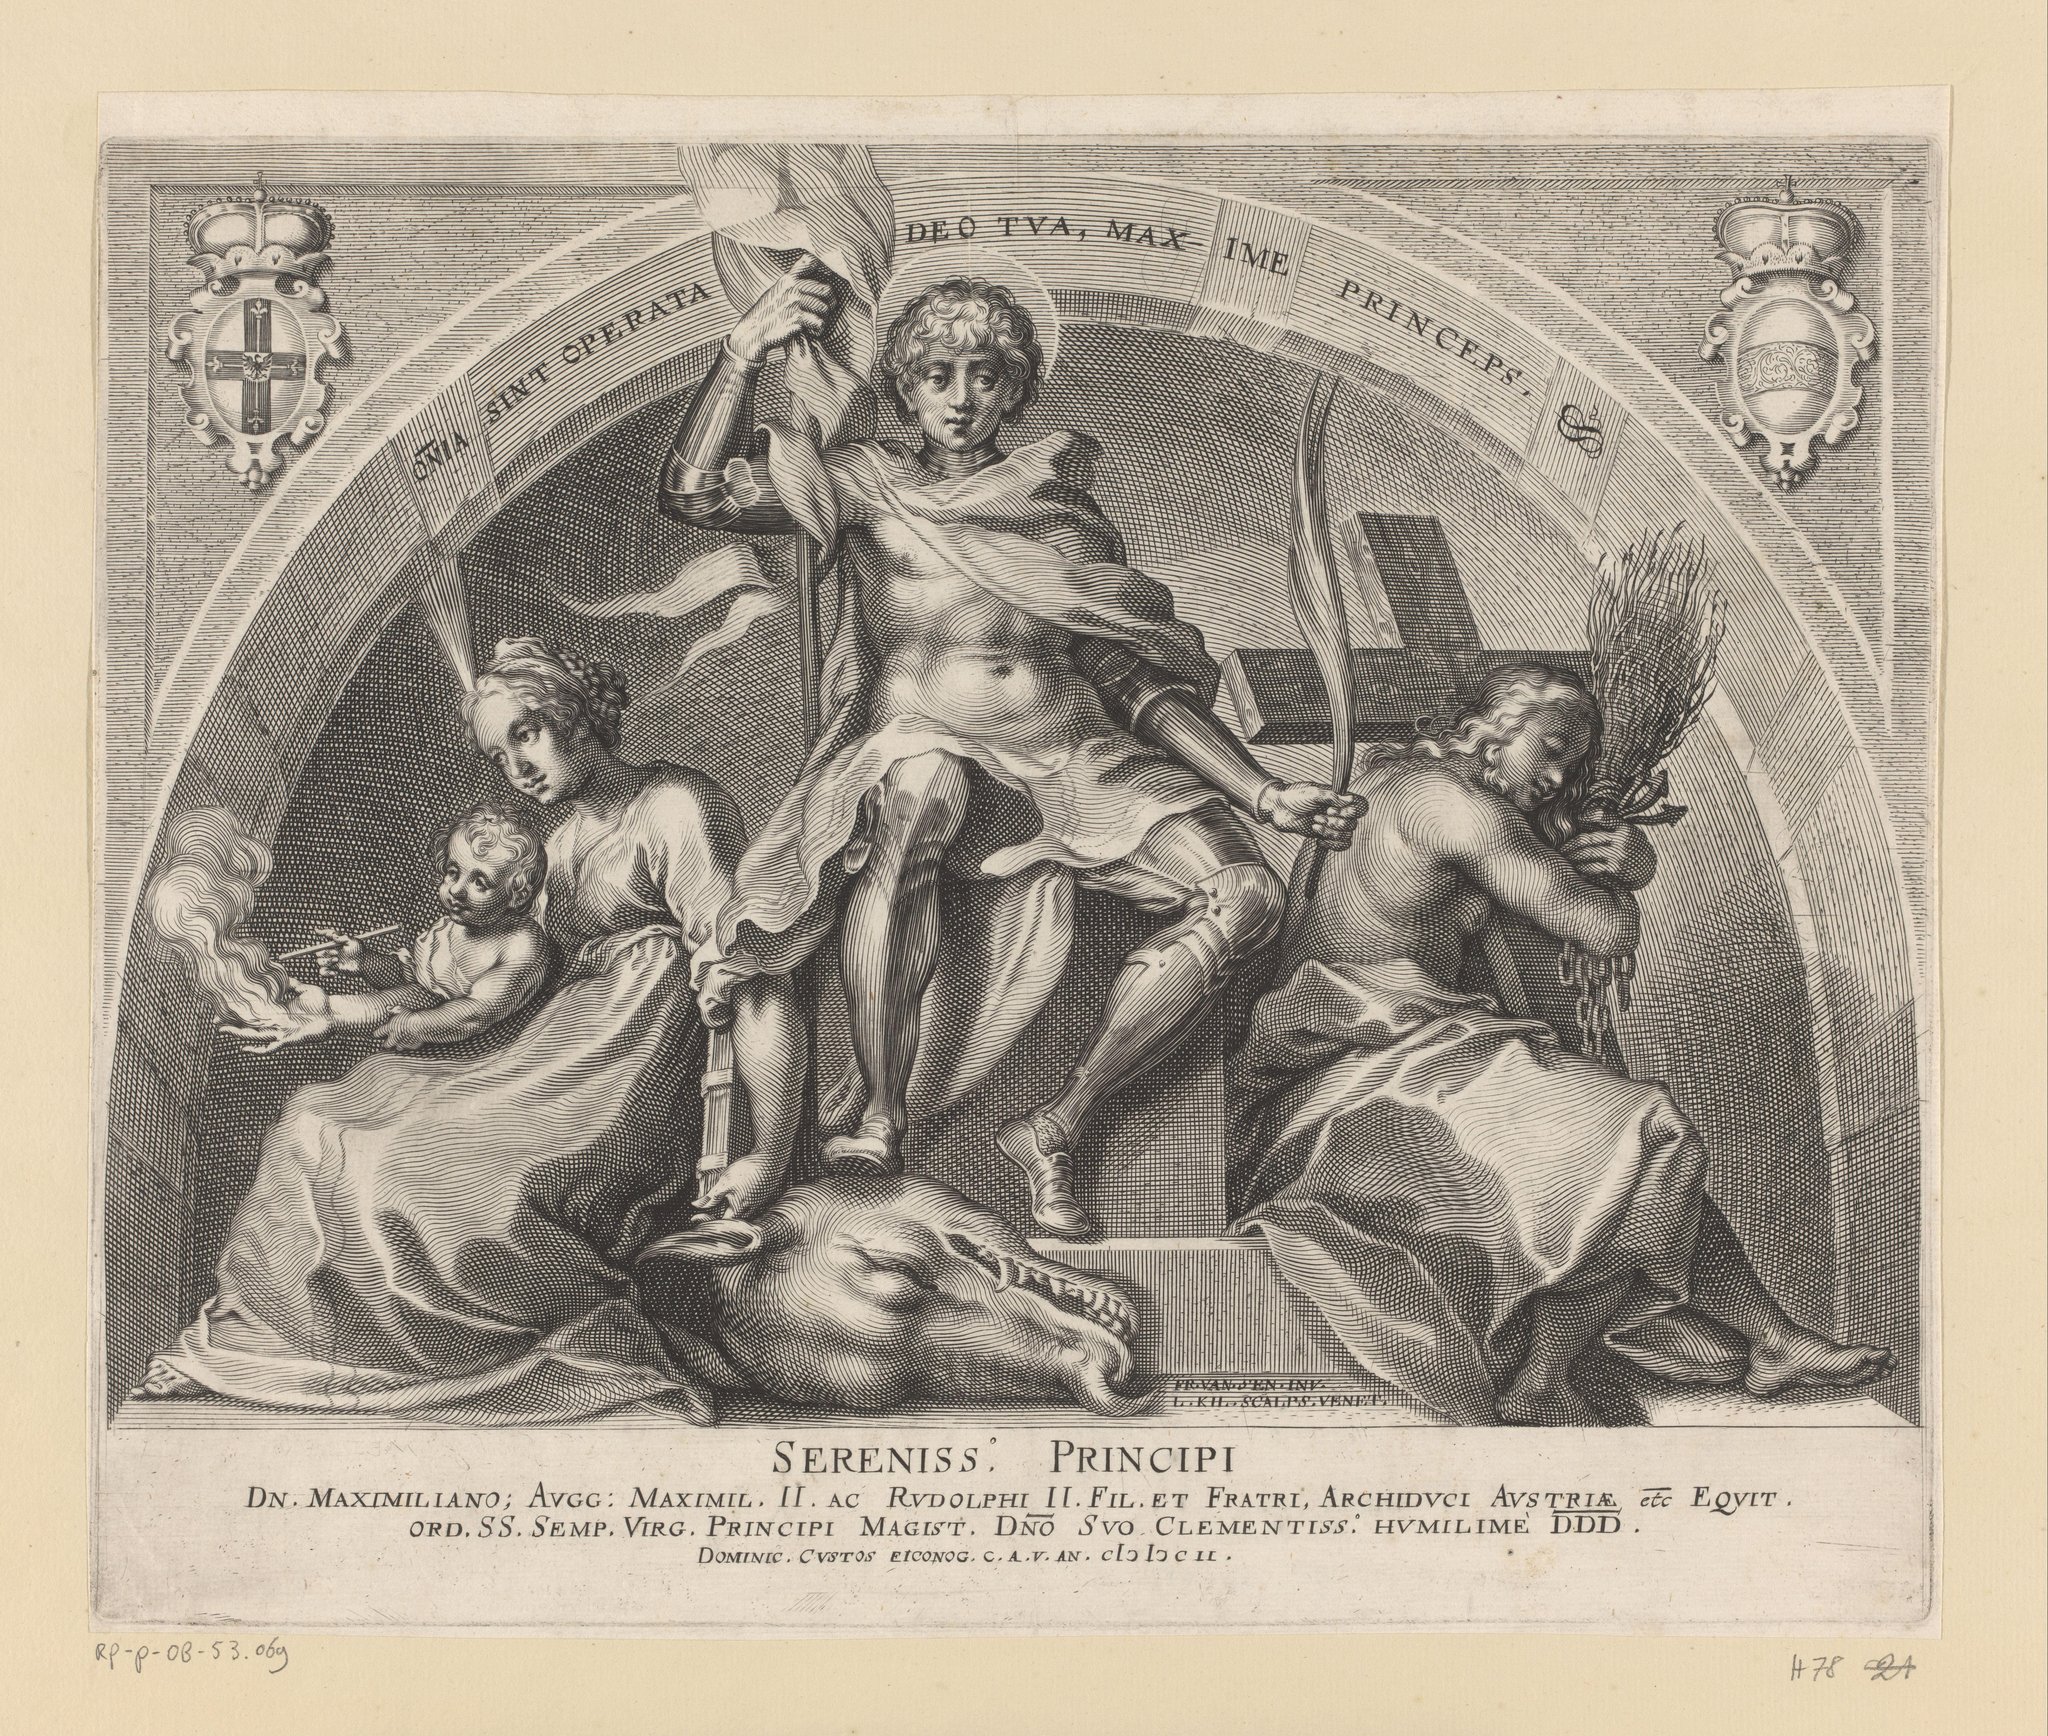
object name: print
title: H. George met H. Margaretha en Maria Magdalena aan weerszijden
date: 1602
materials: paper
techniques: engraving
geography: venice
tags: the virgin martyr margaret of antioch; possible attributes: cross, crown, dragon (under feet or on chain), (chaplet of) pearls, the warrior martyr george (georgius); possible attributes: banner (red cross on white field), (red) cross, dragon, (white) horse, broken lance, shield (with cross), sword, the penitent harlot mary magdalene; possible attributes: book (or scroll), crown, crown of thorns, crucifix, jar of ointment, mirror, musical instrument, palm-branch, rosary, scourge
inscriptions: collector's mark: Lugt 240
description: Tekst in het Latijn in de ondermarge en in de boog bovenaan.